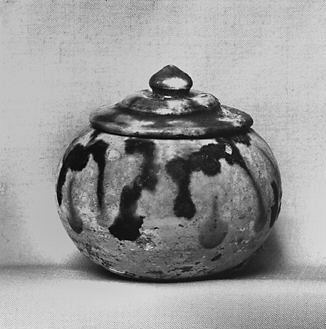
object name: jar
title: Miniature covered jar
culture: chinese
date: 601-800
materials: earthenware, glaze